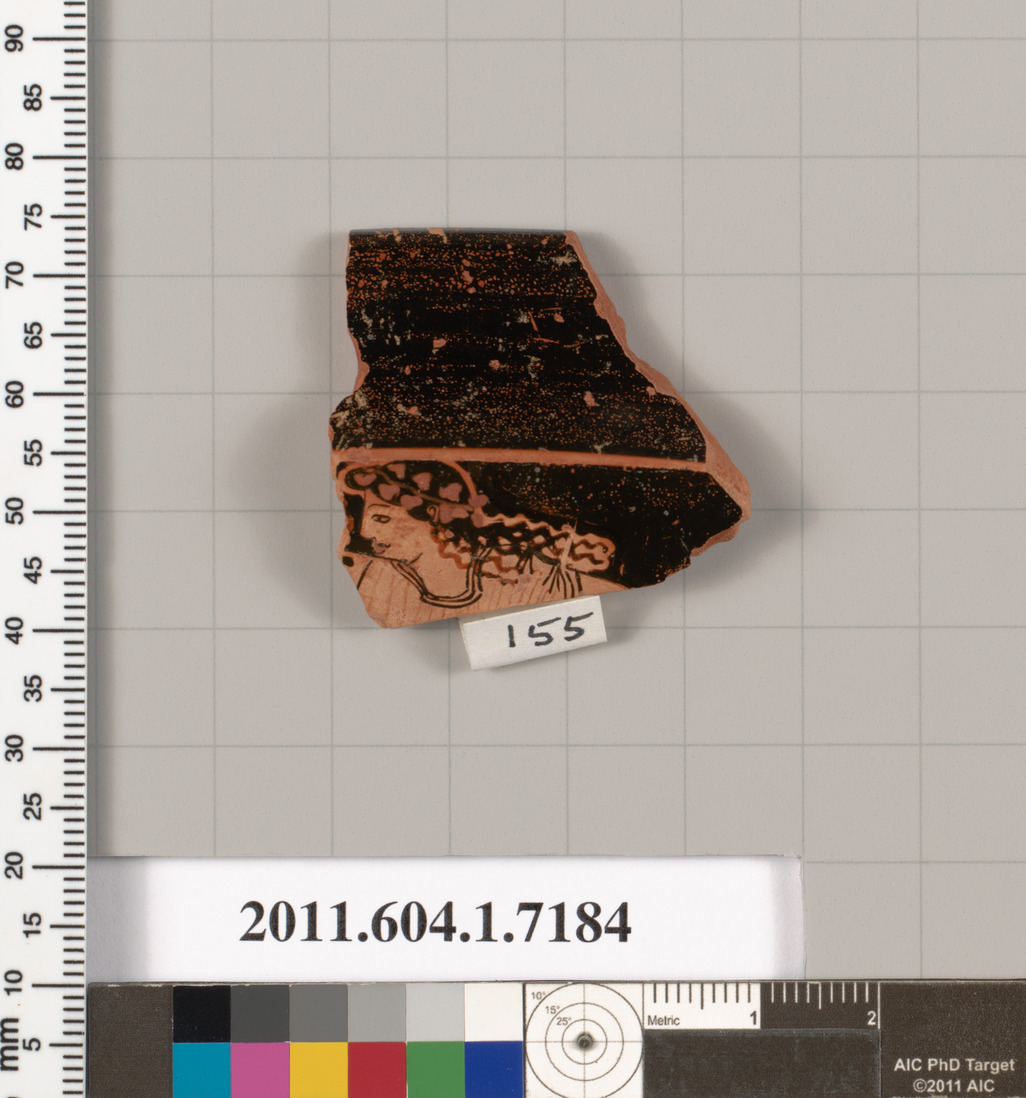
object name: kylix fragment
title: Terracotta rim fragment of a kylix (drinking cup)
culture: greek, attic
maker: makron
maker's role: artist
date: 500-480 BCE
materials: terracotta